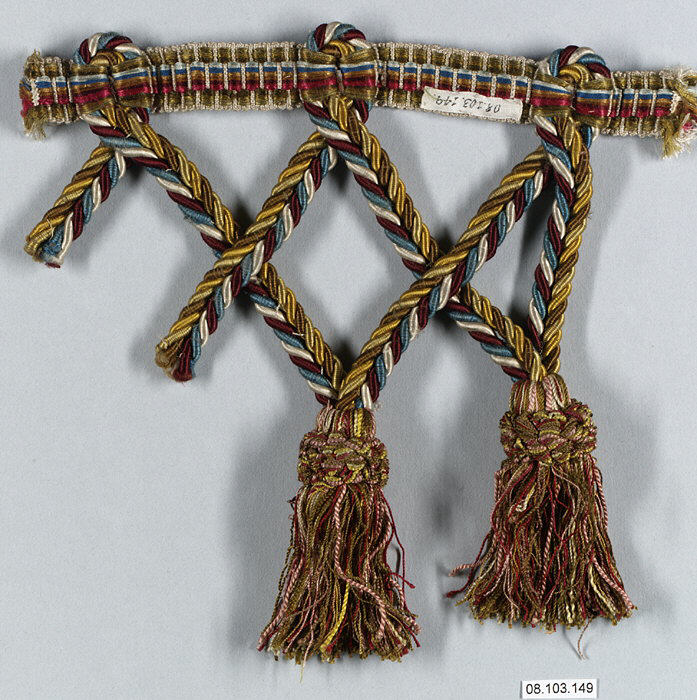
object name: fringe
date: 1801-1900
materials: silk